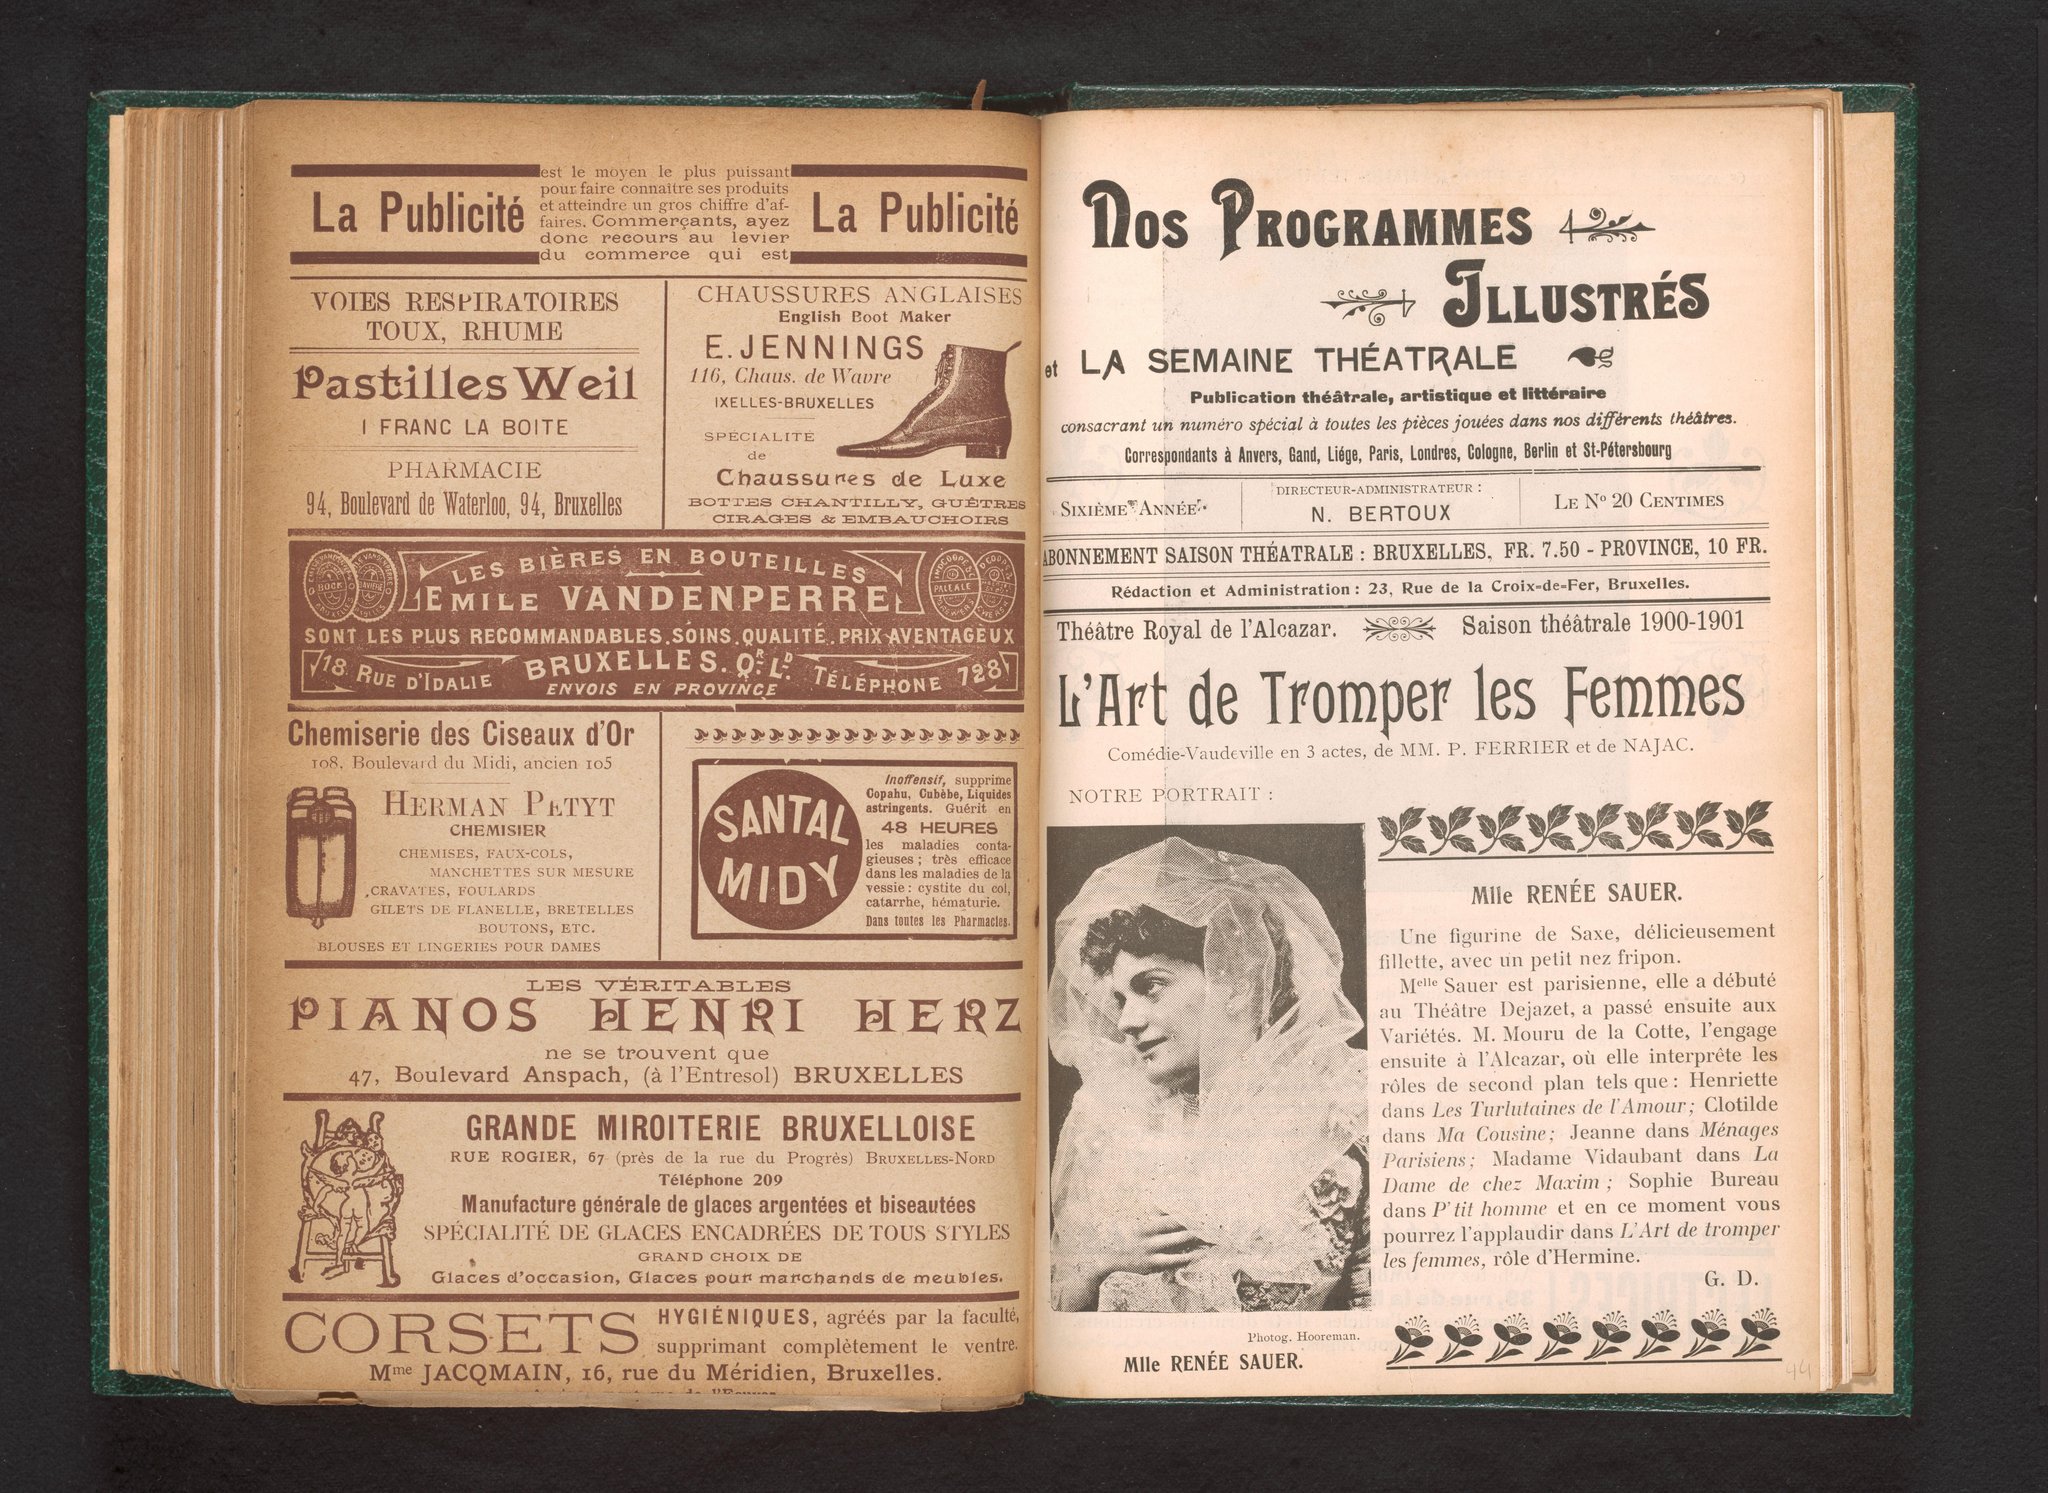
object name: photomechanical print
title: Mlle Renée Sauer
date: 1895-1900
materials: paper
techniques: autotype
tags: adult woman, historical persons